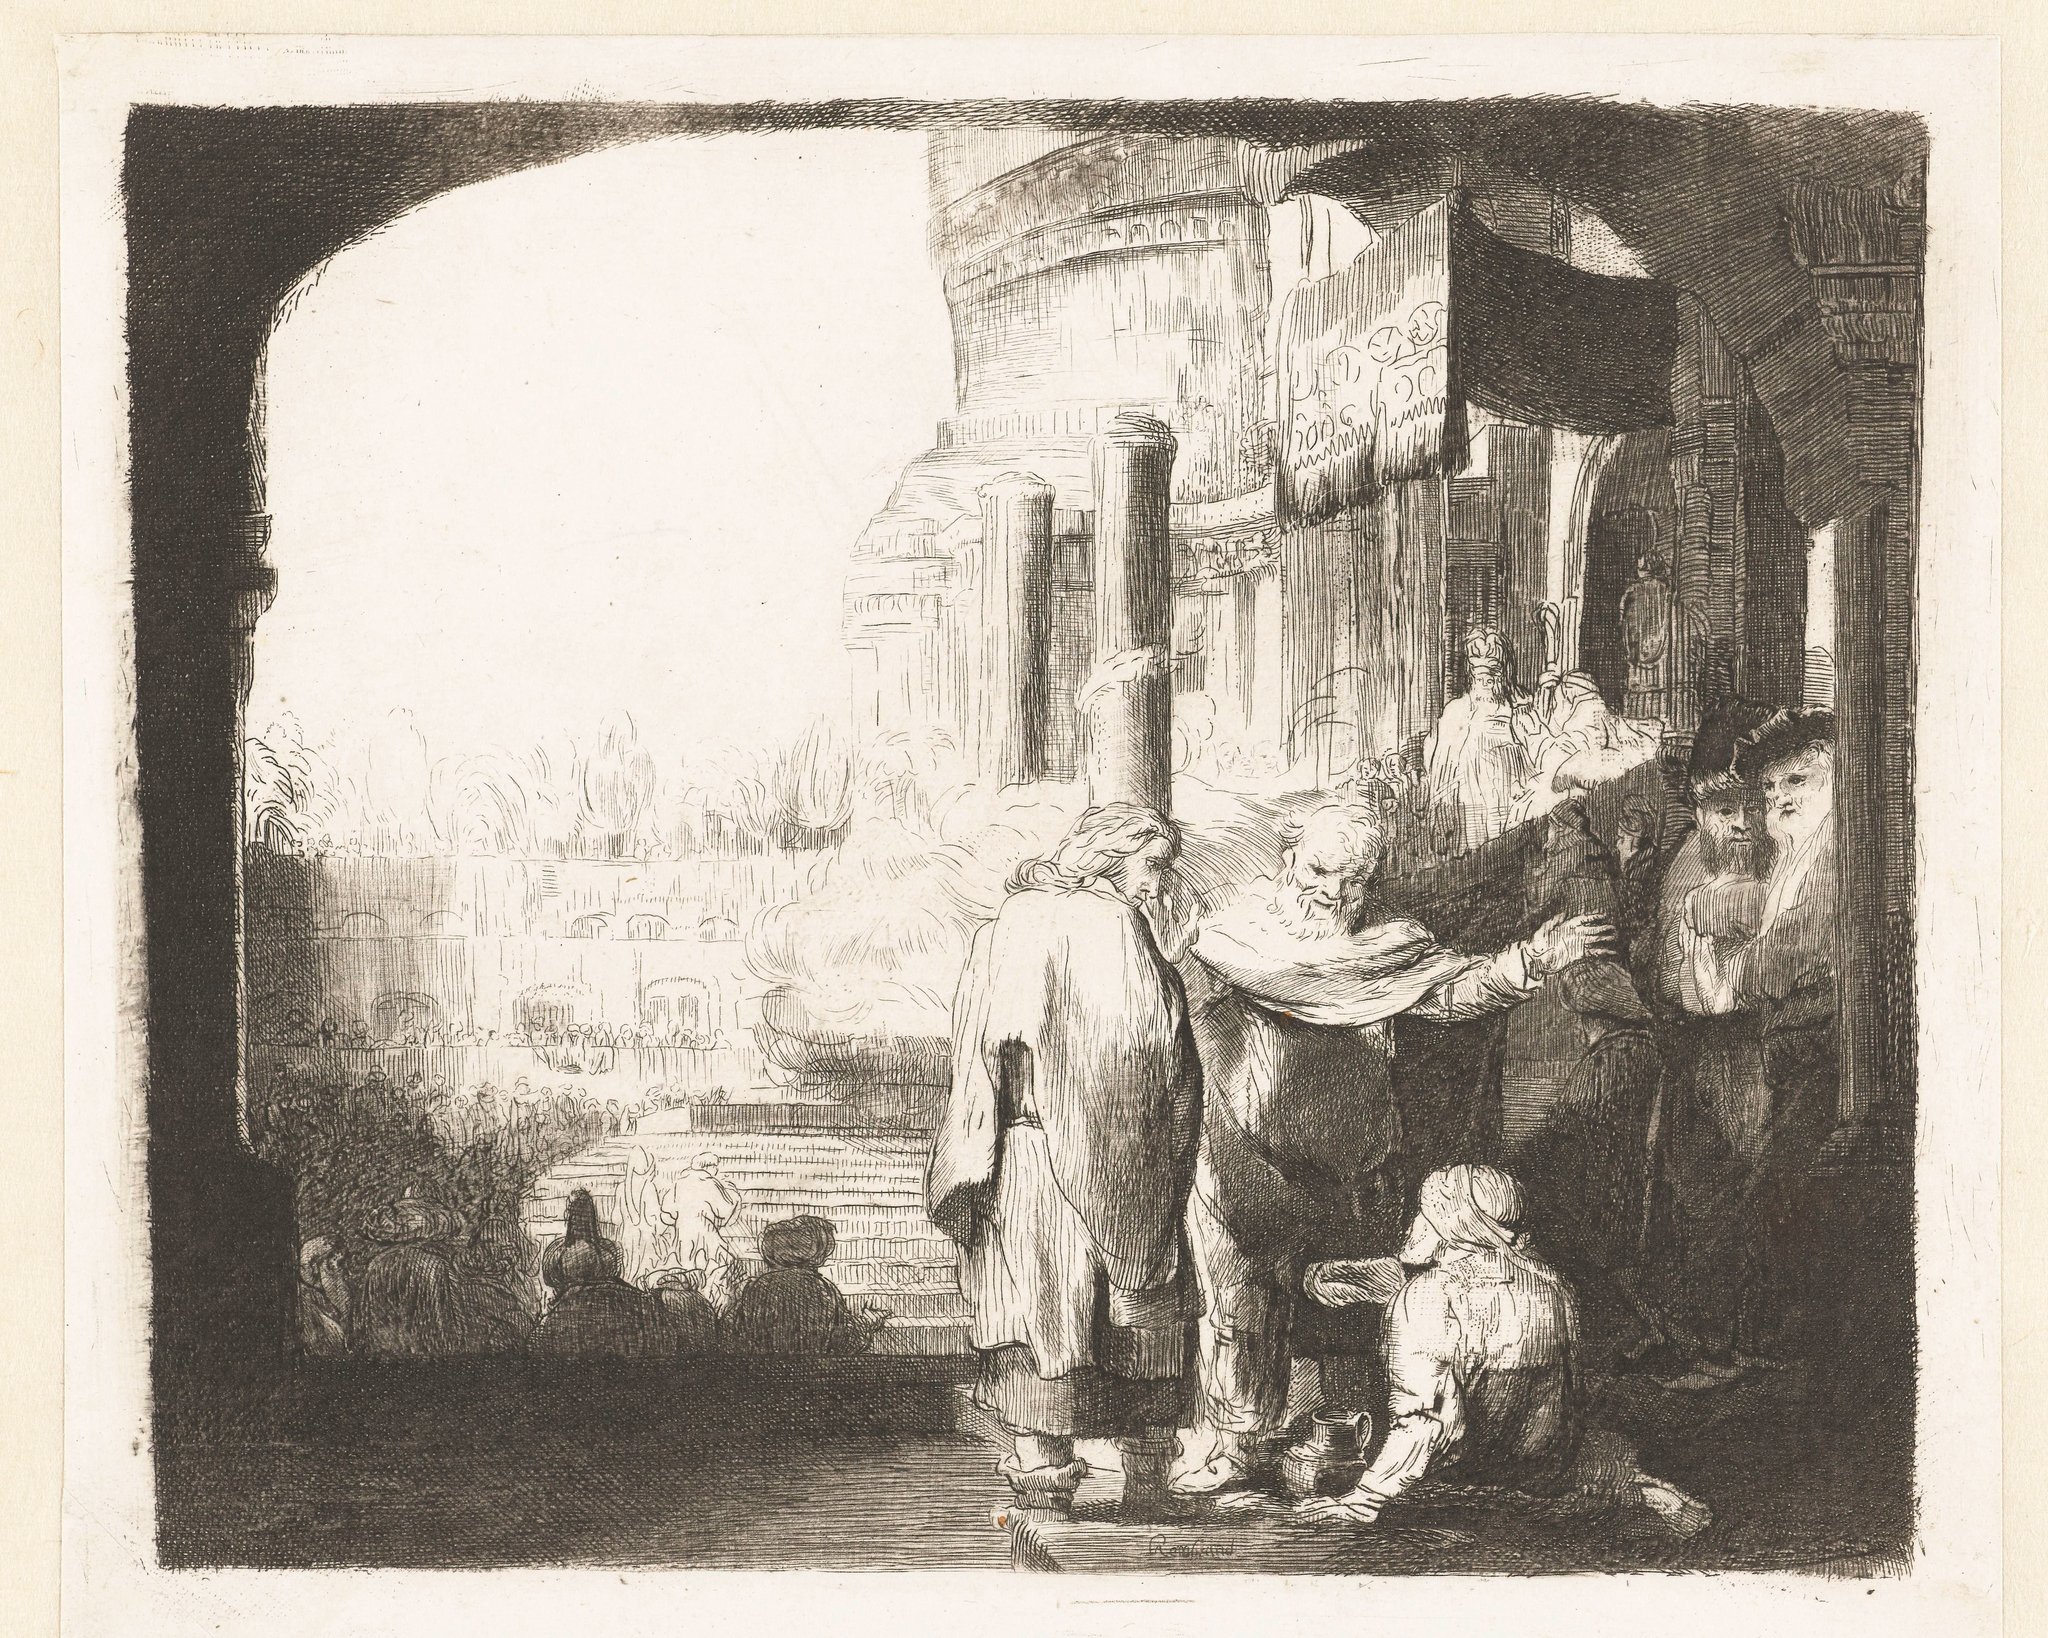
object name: print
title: Peter and John healing the cripple at the gate of the temple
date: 1659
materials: paper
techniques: etching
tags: healing of a lame beggar at the beautiful gate of the temple by peter and john (acts 3 - 4:31), disabilities, deformations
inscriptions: collector's mark: Lugt 2760, collector's mark: Lugt 2228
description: Spiegelbeeldige kopie naar de gelijknamige prent van Rembrandt. De voorstelling is gebaseerd op de tekst uit Handelingen 3:4-31. In de Statenvertaling is de bedelaar beschreven als: “En een zeker man, die kreupel was van zijner moeders lijf, werd gedragen, welken zij dagelijks zetten aan de deur des tempels (…) Maar Petrus zei (…) In den Naam van Jezus Christus den Nazaréner, sta op en wandel. En hem grijpende bij de rechterhand, richtte hij hem op, en terstond werden zijn voeten en enkels vast”. In de Nieuwe Bijbelvertaling wordt er niet gesproken over ‘kreupel’ maar over verlamming: “Men had ook een man die al sinds zijn geboorte verlamd was naar de tempel gebracht (…) Maar Petrus zei (…) in de naam van Jezus Christus van Nazareth, sta op en loop.’ Hij pakte hem bij zijn rechterhand om hem overeind te helpen. Onmiddellijk kwam er kracht in zijn voeten en enkels.”